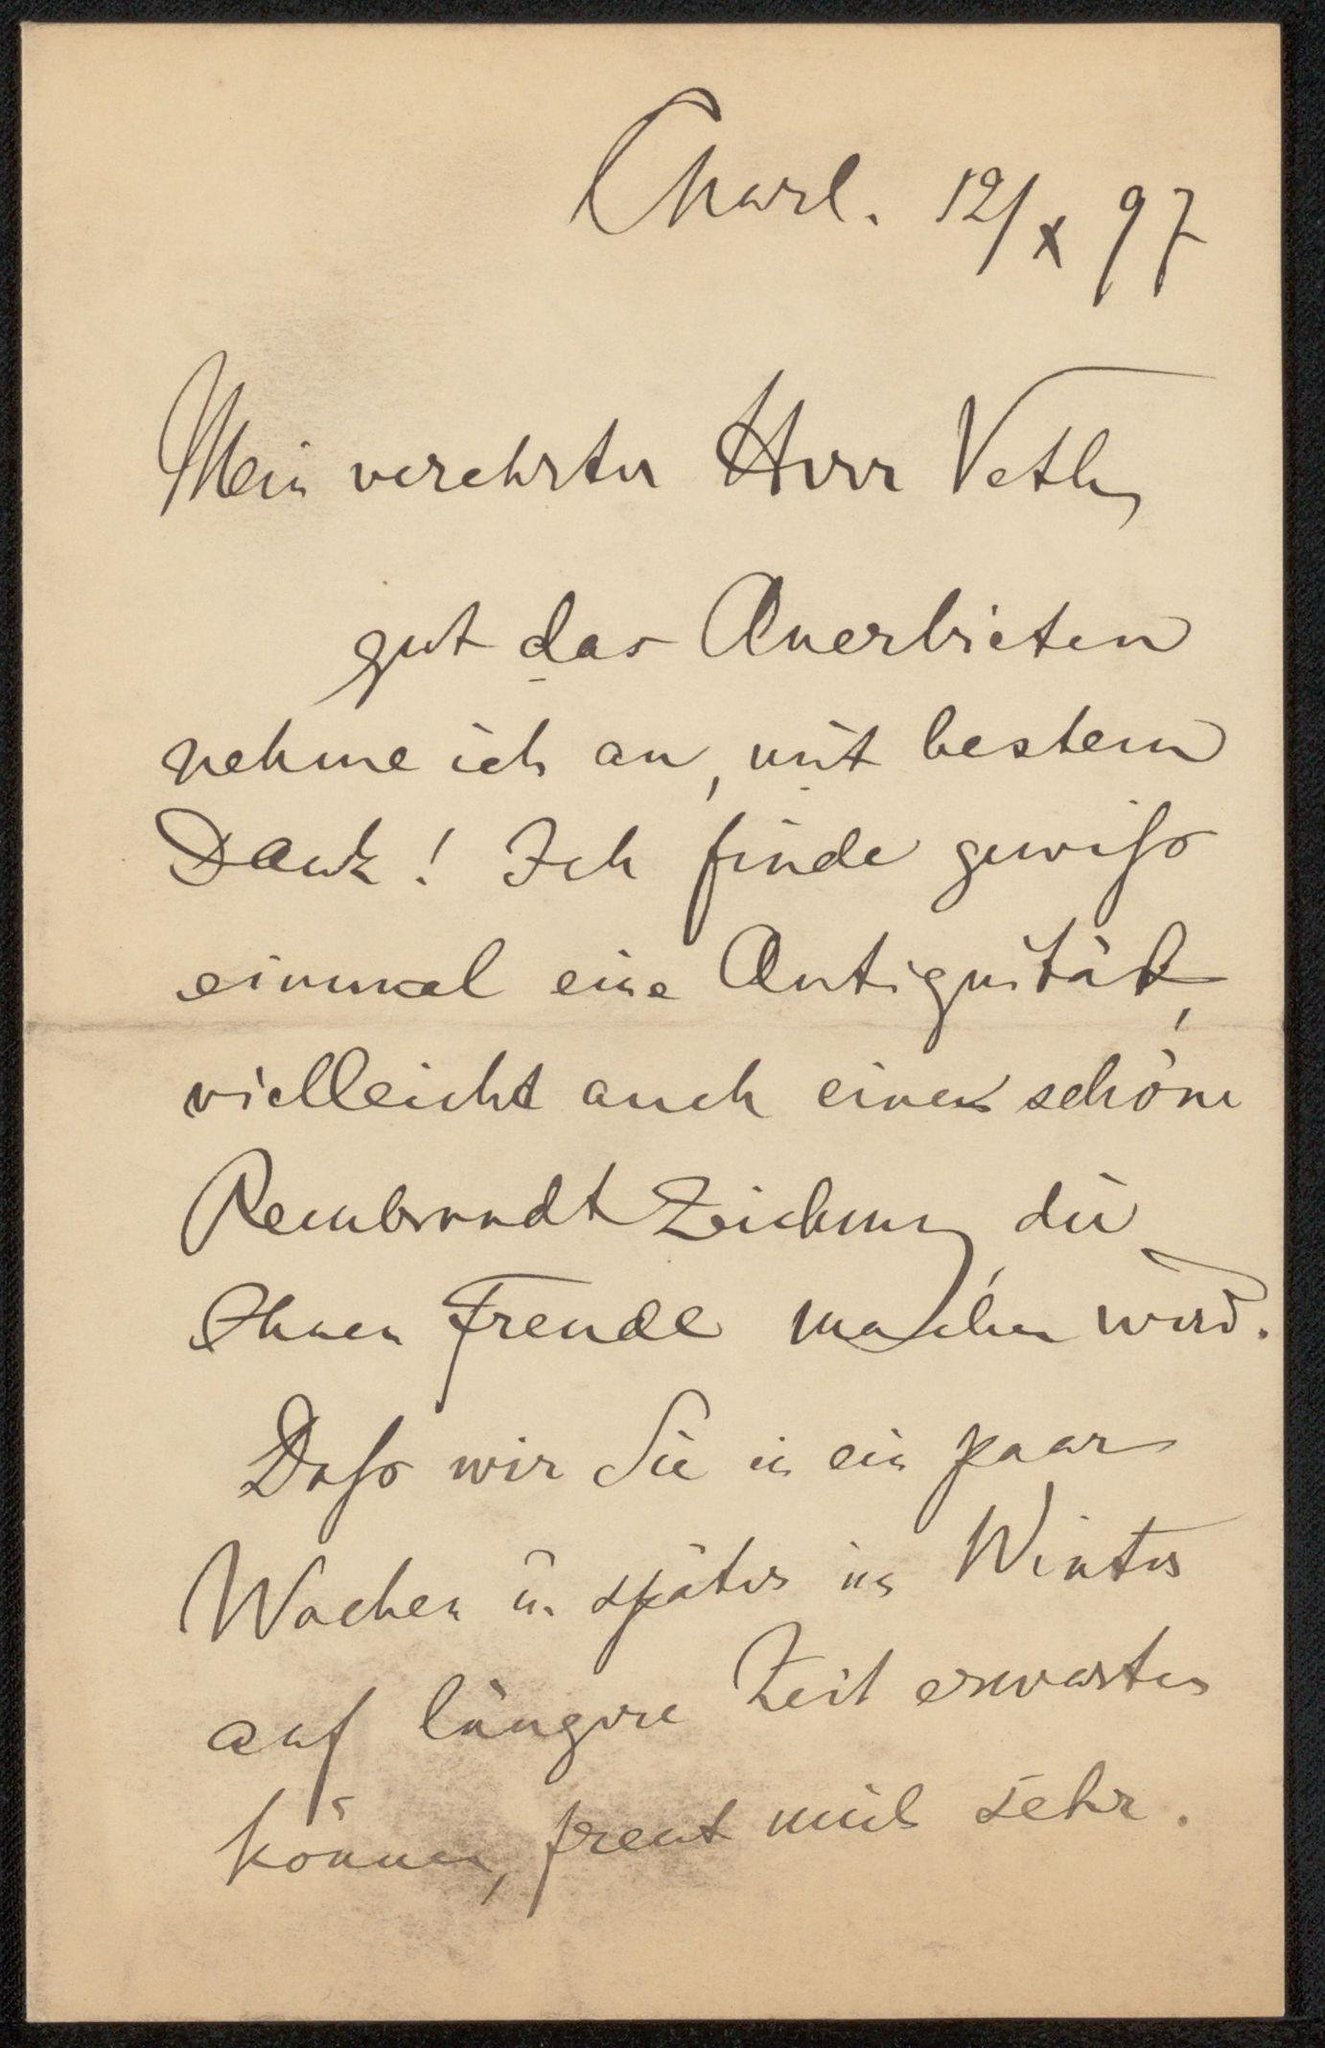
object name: letter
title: Brief aan Jan Veth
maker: wilhelm von bode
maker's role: conservator, kunsthistoricus, museumdirecteur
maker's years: 1845-1929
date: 1897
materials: ink, paper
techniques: pen, writing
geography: charlottenburg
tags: the hague, jozef israëls, dordrecht, painter, designer, jan veth, berlin, print maker, draughtsman, max liebermann, leiden, rembrandt van rijn, printed matter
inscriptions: collector's mark: ‘RPK’